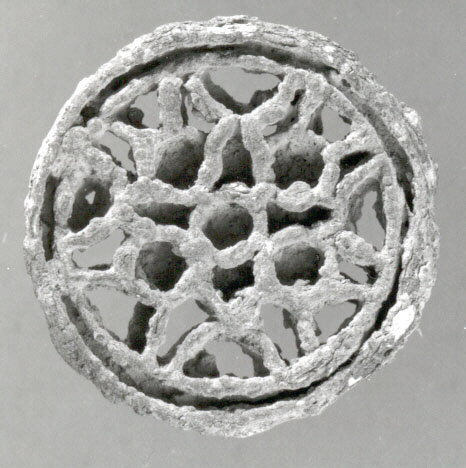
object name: stamp seal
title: Compartmented stamp seal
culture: bactria-margiana archaeological complex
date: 2333-1668 BCE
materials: copper alloy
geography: bactria-margiana